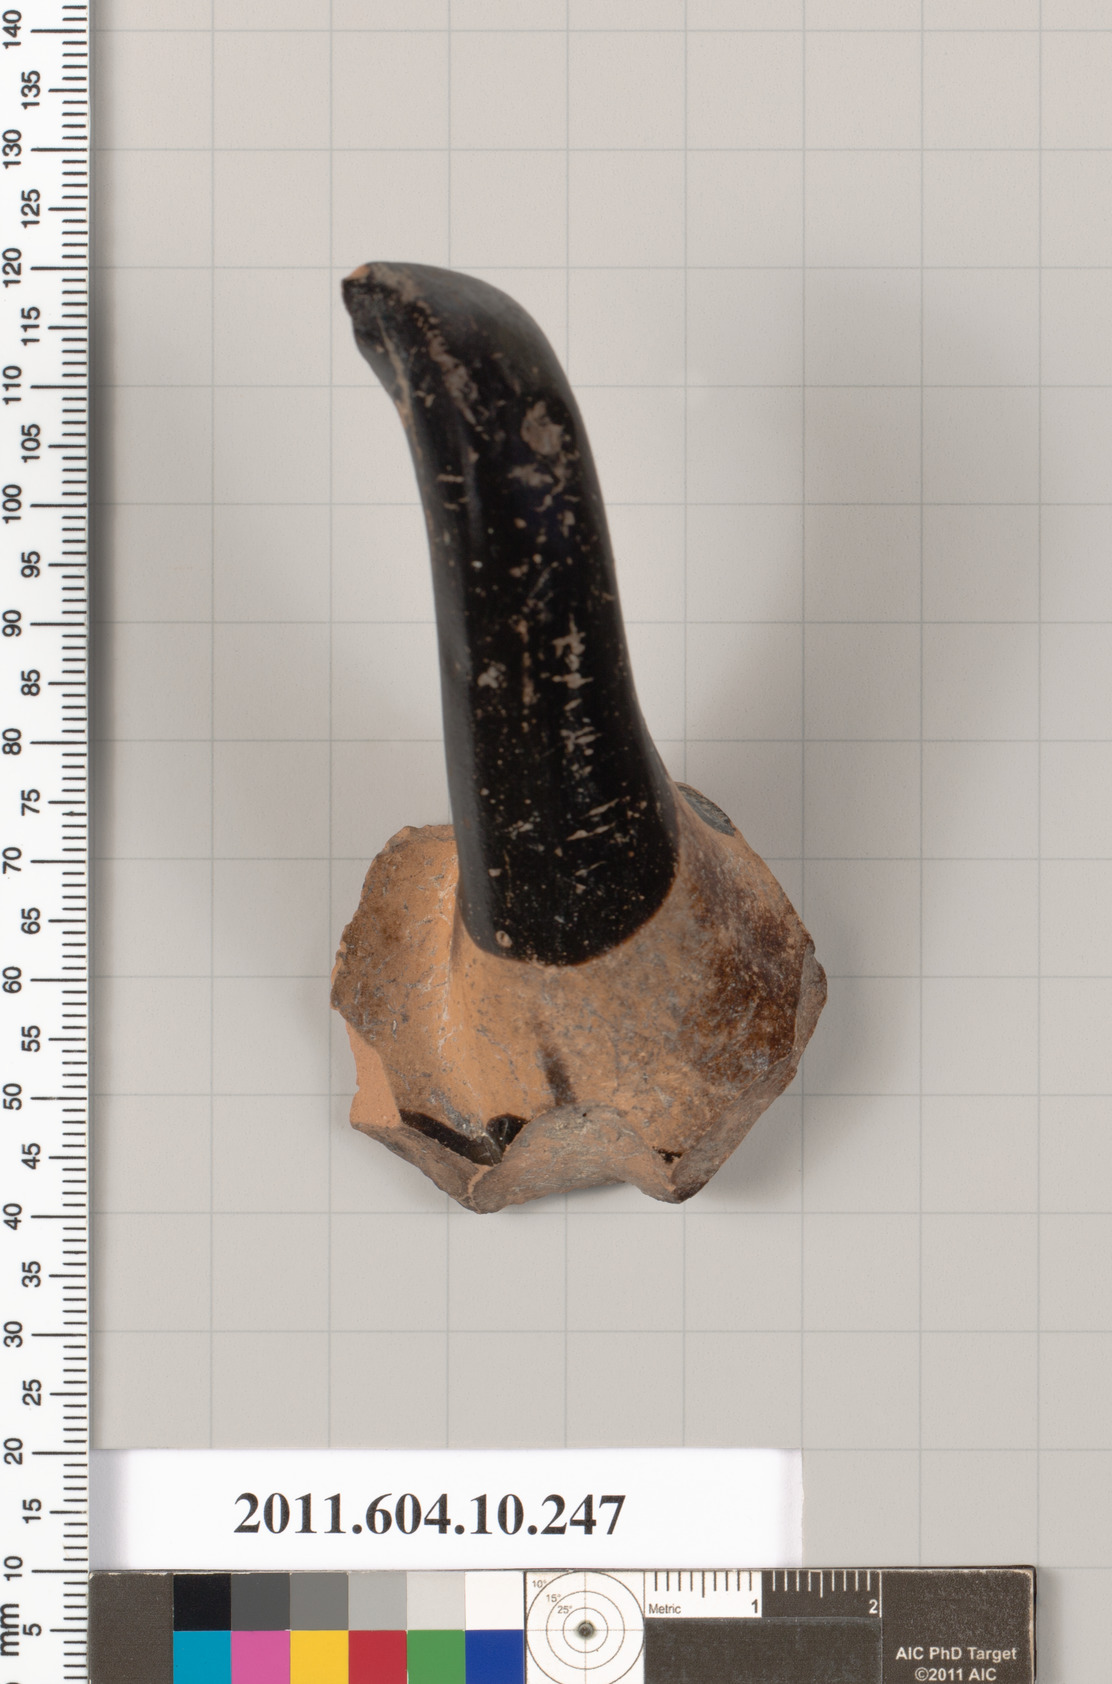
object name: krater fragment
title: Terracotta fragment of a krater (deep bowl)?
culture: etruscan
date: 500-301 BCE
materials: terracotta